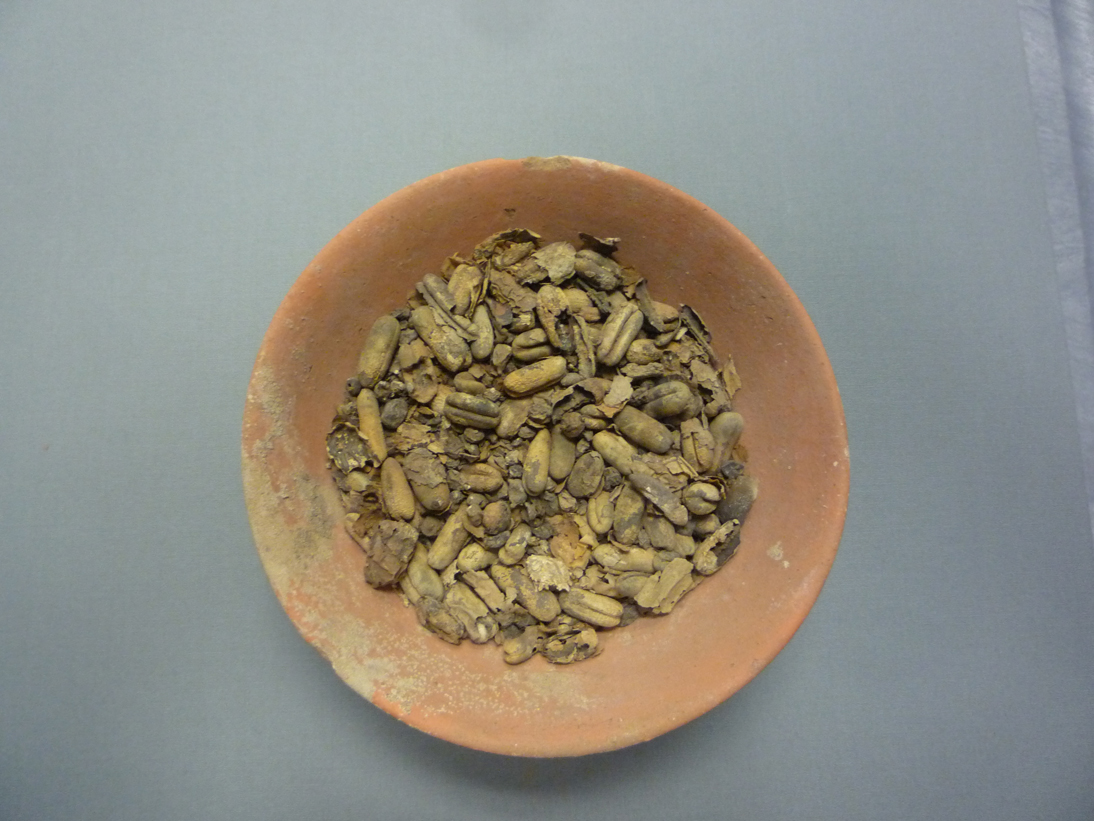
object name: bowl, date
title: Bowl of Dates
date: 1479-1458 BCE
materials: pottery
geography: egypt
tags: fruit